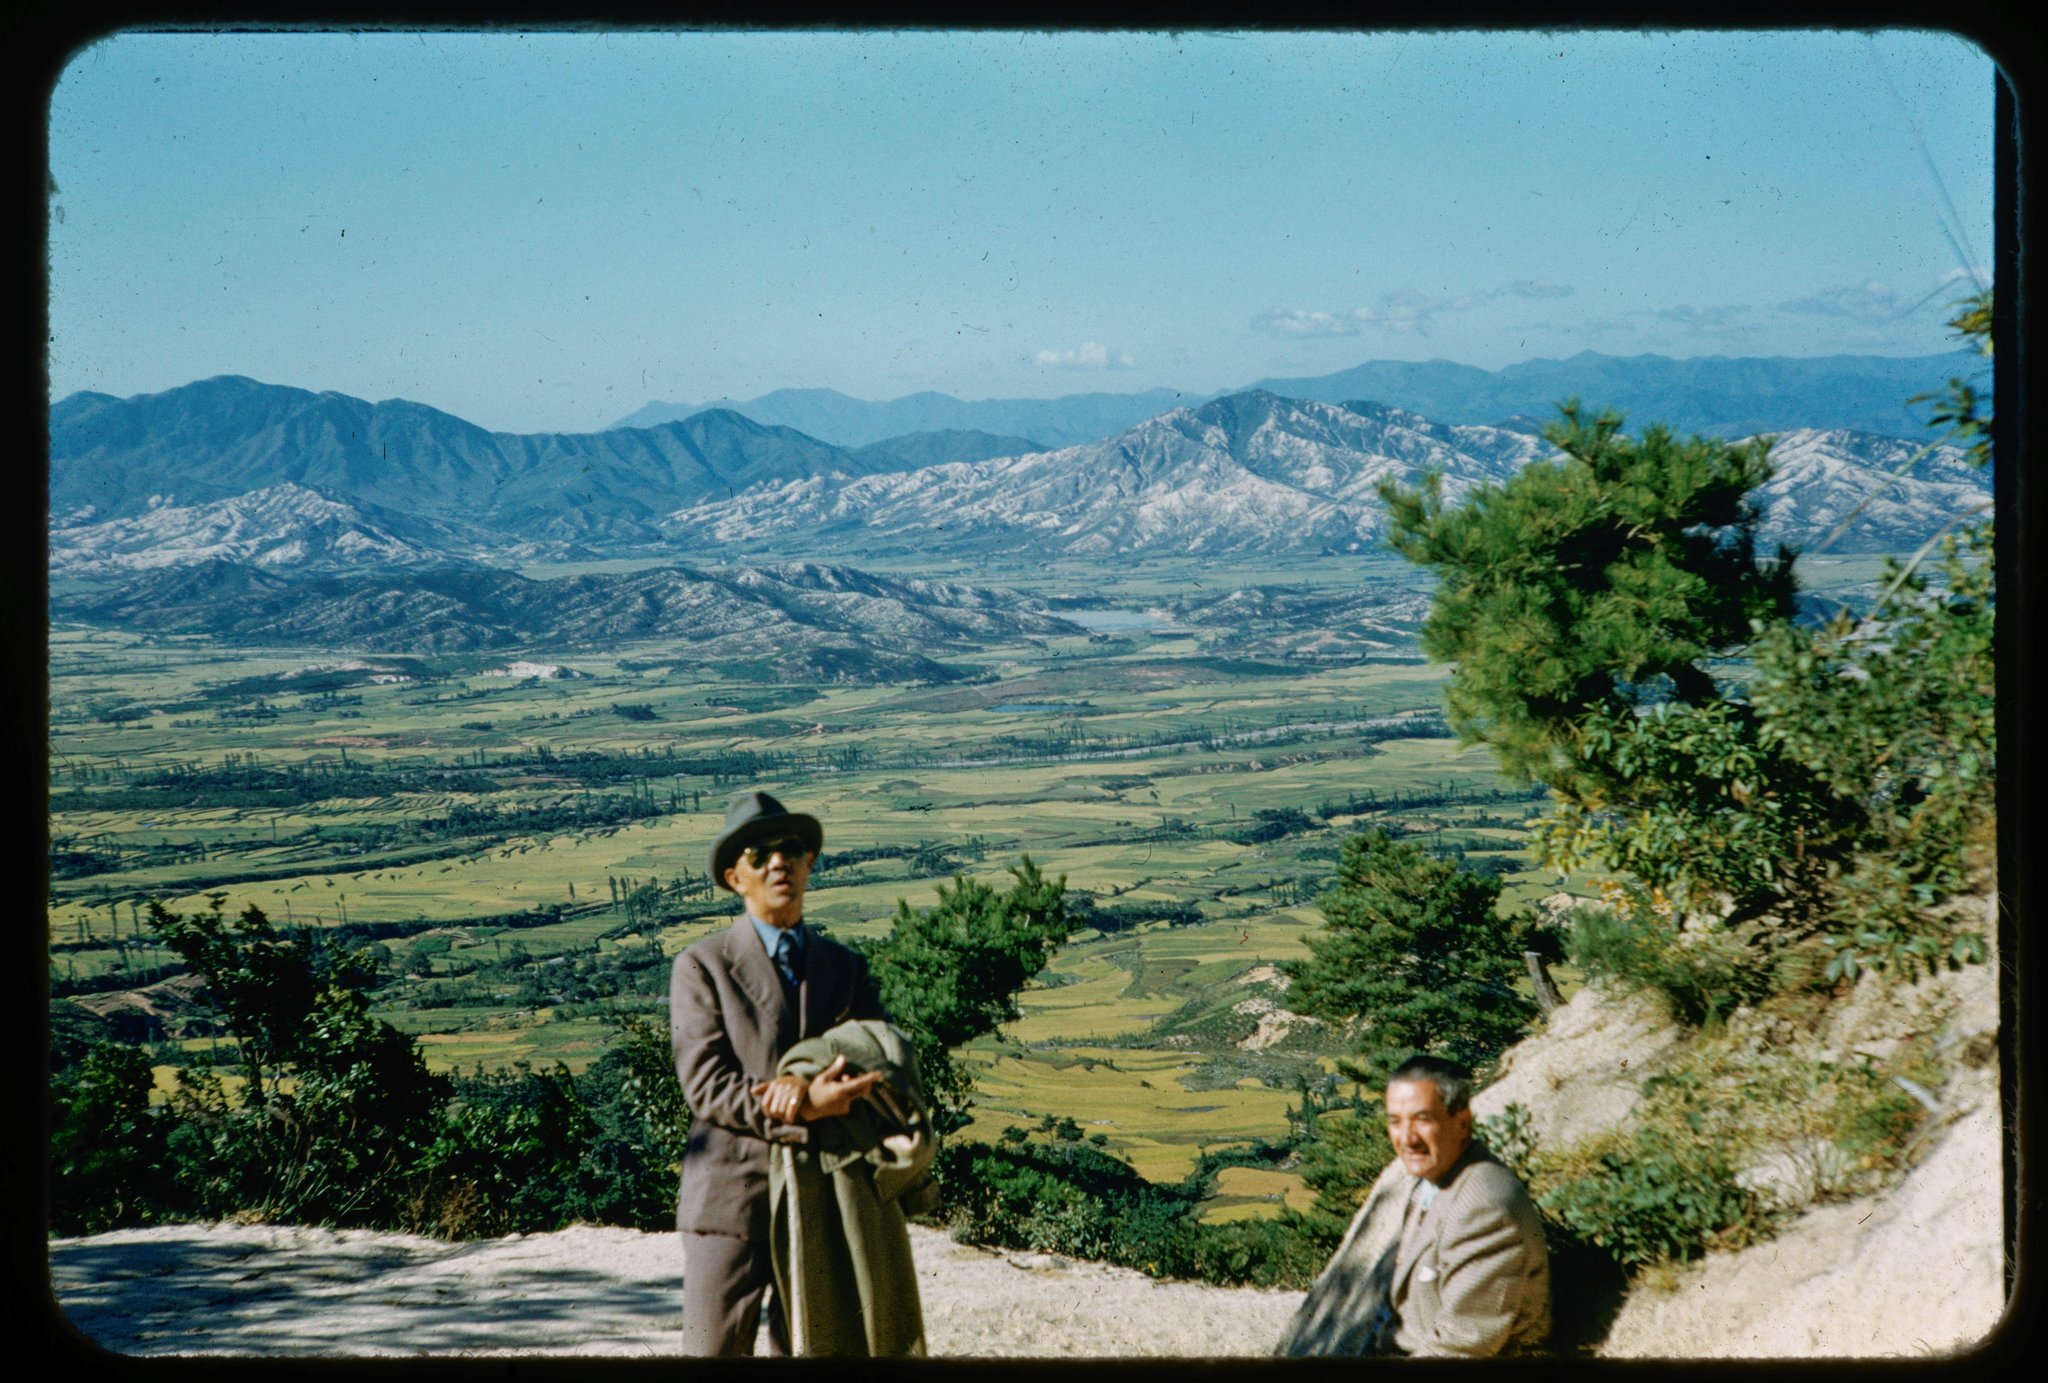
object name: color slide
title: Een Europese man met de Koreaanse Prins Fridi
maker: david ketel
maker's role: diplomaat, sinoloog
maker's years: 1913-2008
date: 1952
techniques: slide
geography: korea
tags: united nations